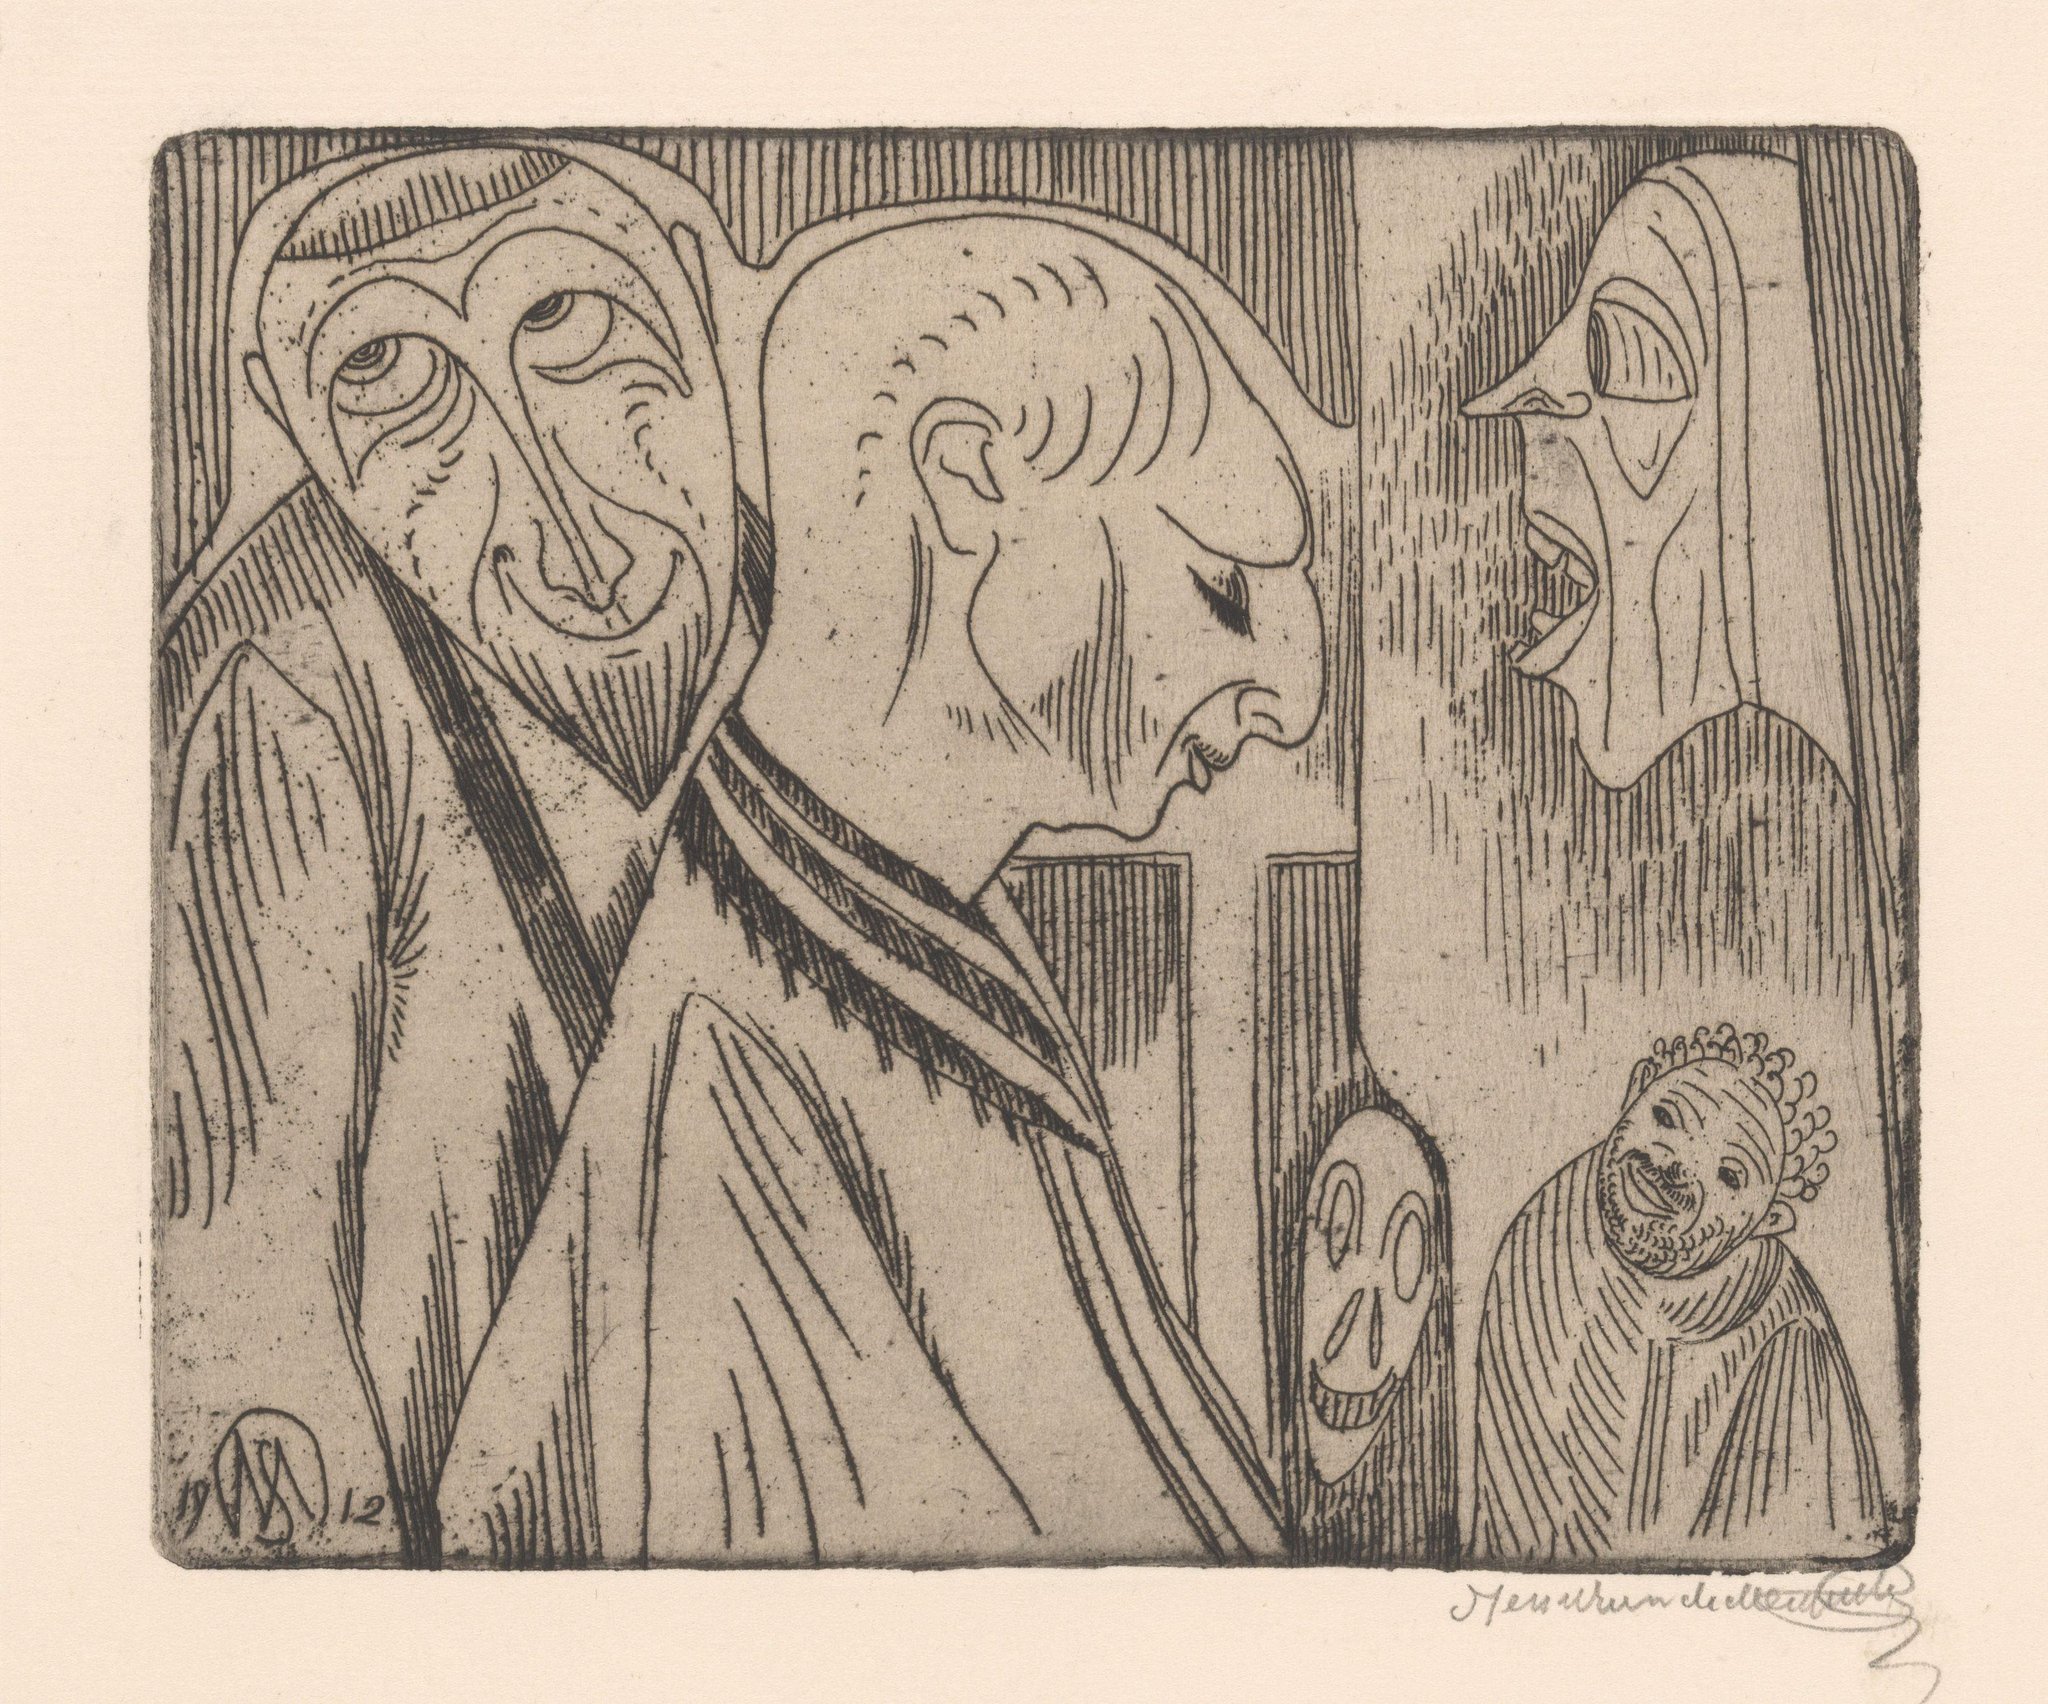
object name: print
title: Groteske verbeelding: diverse figuren, twee grote links in beeld, de een frontaal, de ander (met geloken oog) in profiel naar rechts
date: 1912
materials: paper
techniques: etching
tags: mask, mouth wide open, caricatures (human types)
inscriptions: collector's mark: Lugt 2228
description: Links een omhoog kijkende figuur met een puntbaard. In het midden een kale figuur met gesloten ogen. Rechts een figuur met een baard en een gezicht met open mond.